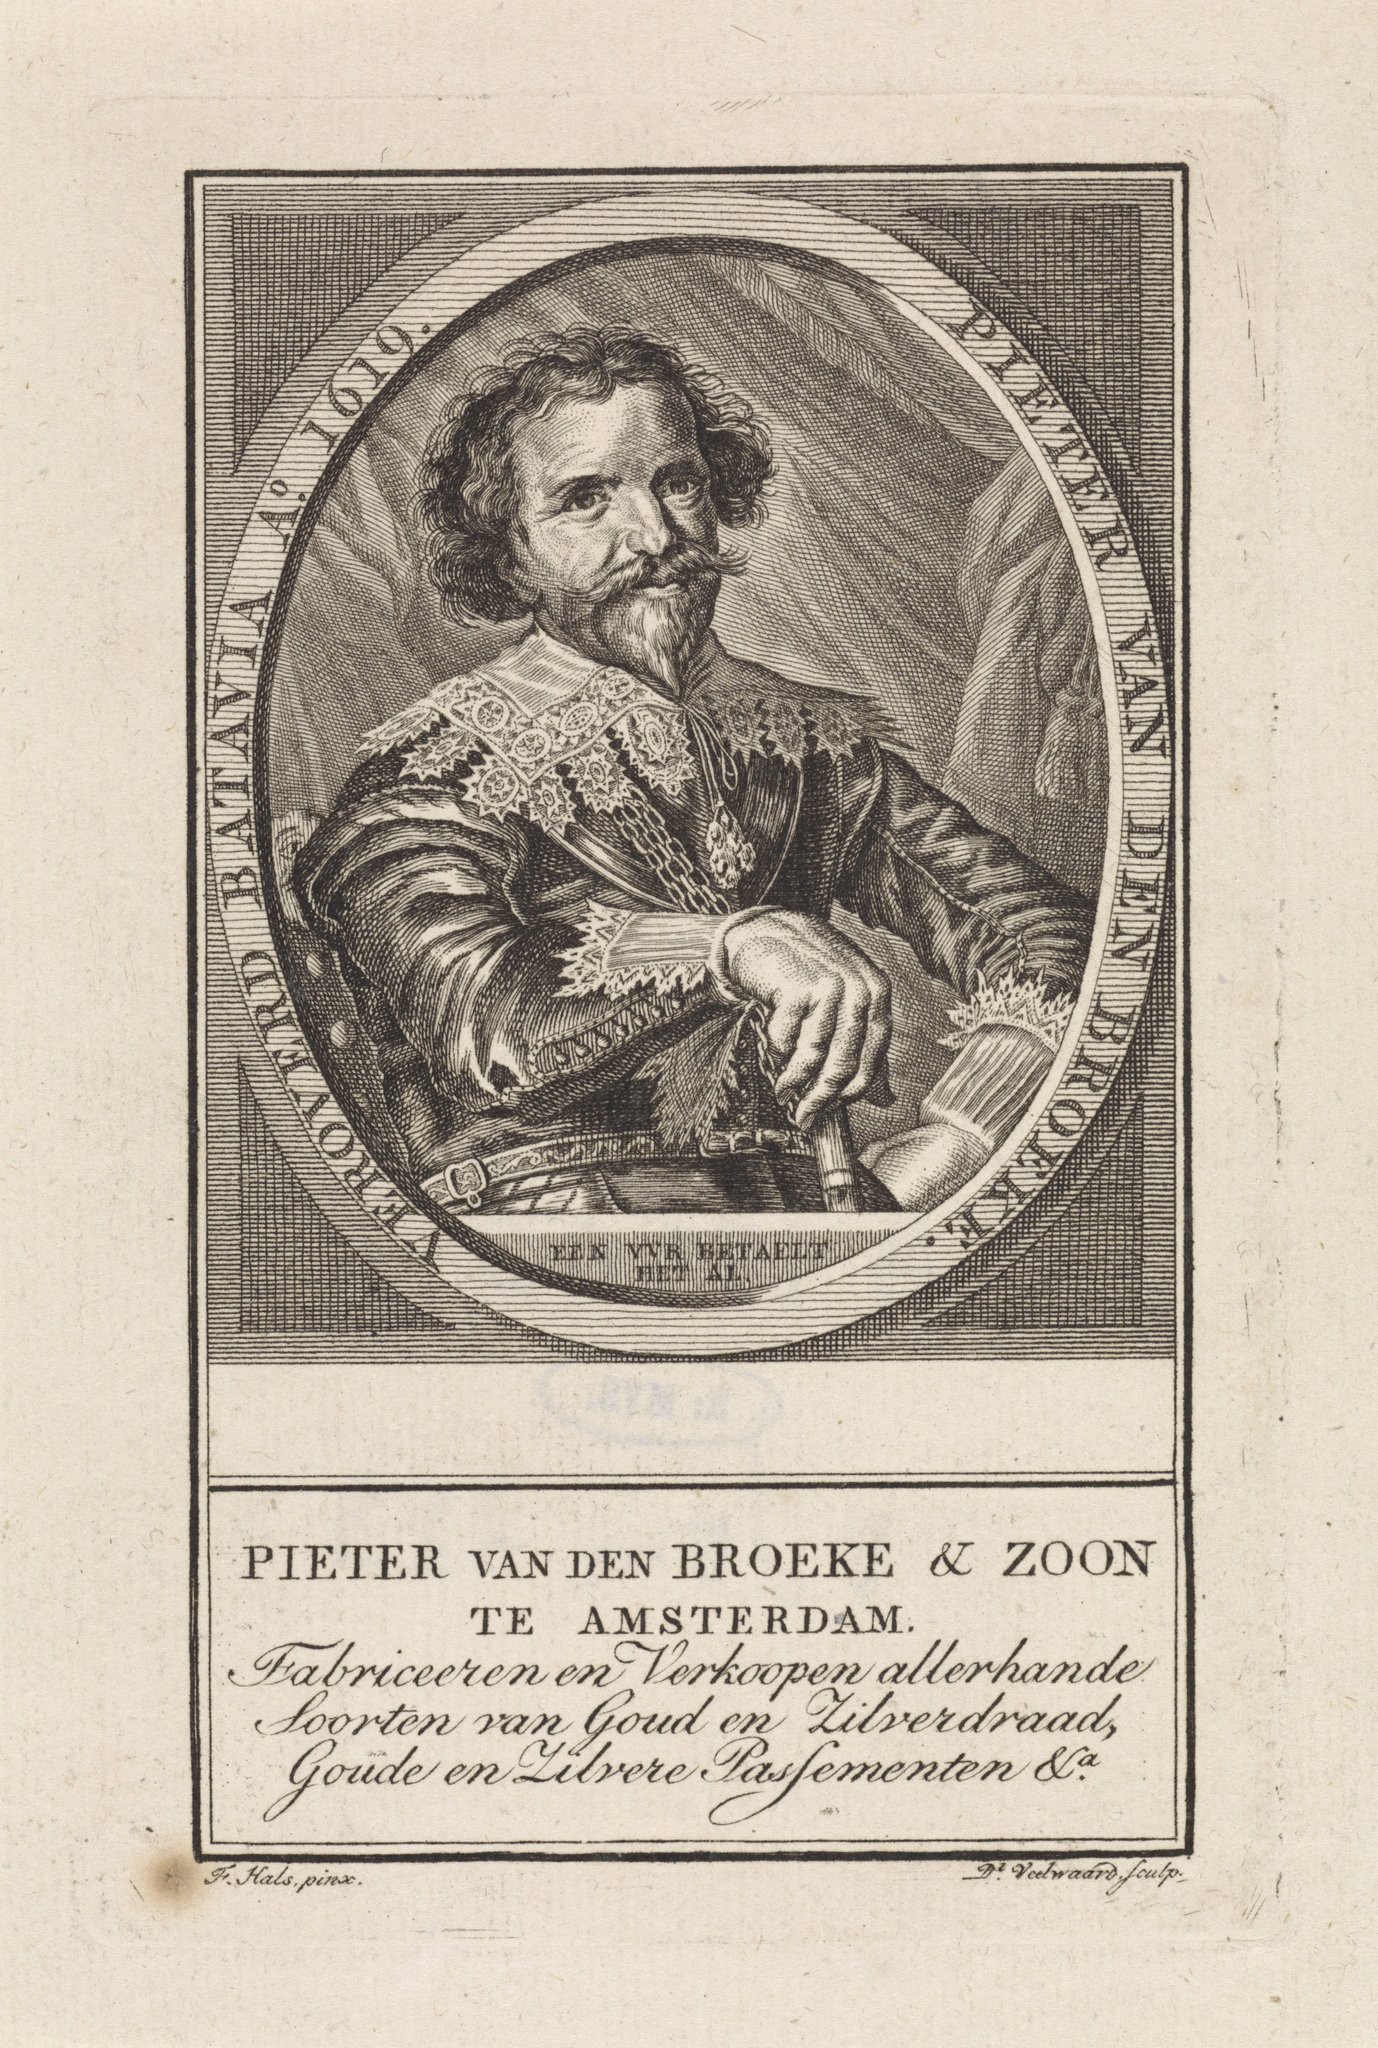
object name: print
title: Portret van de koopman en bewindhebber Pieter van den Broecke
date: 1776-1851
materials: paper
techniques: engraving, etching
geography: amsterdam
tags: antwerp, pieter van den broecke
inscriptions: collector's mark: Lugt 2228